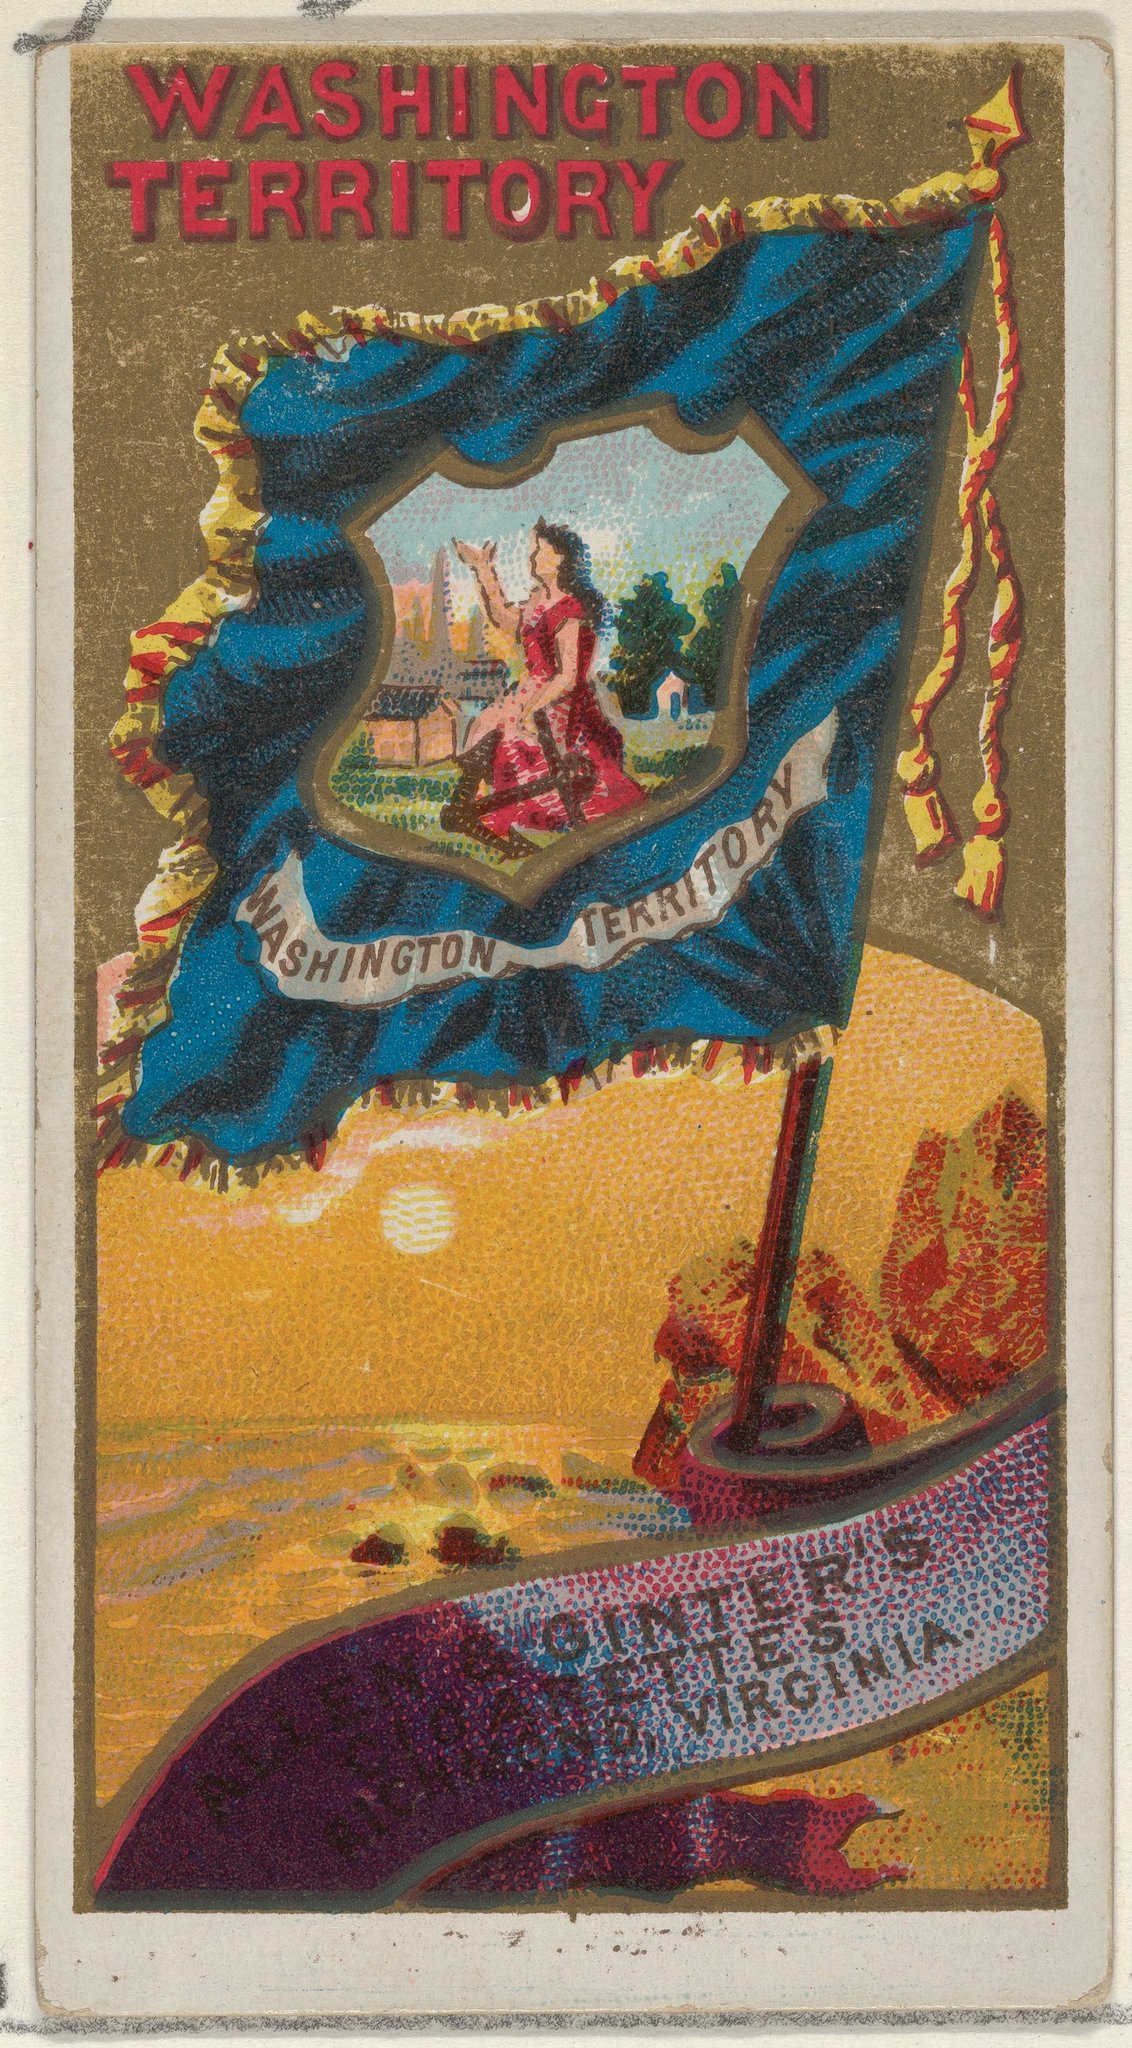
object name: print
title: Washington Territory, from Flags of the States and Territories (N11) for Allen & Ginter Cigarettes Brands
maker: allen & ginter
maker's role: publisher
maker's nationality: american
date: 1888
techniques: color lithograph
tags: flags